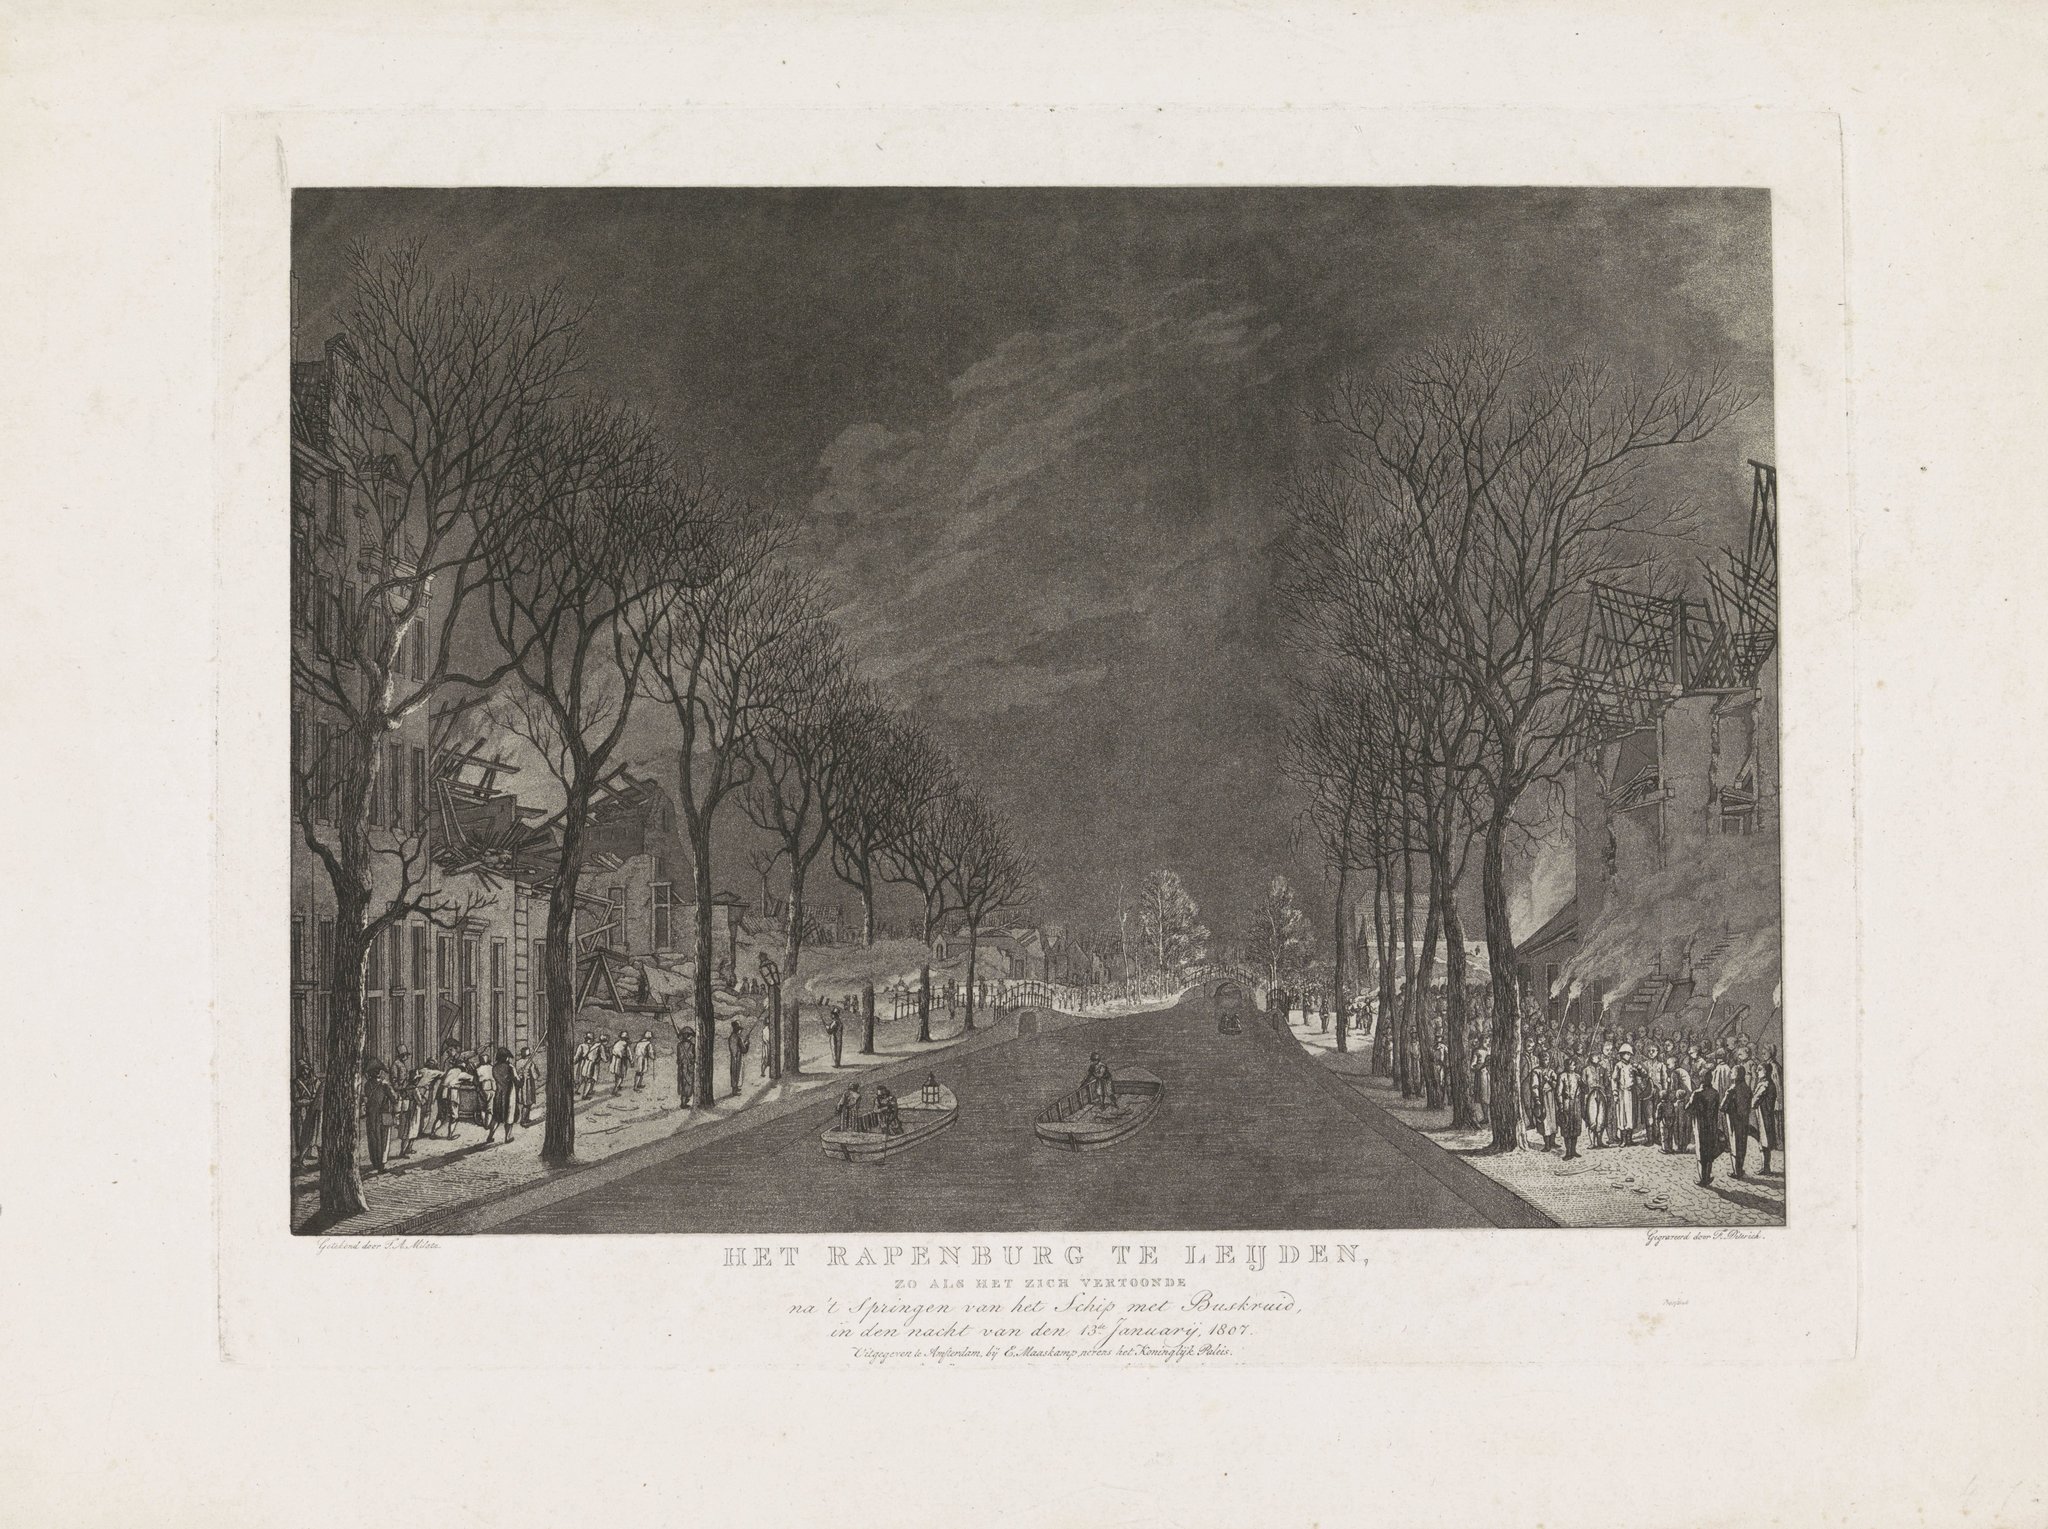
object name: print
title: Lodewijk Napoleon op de plaats van de ramp, 1807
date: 1807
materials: paper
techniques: aquatint, etching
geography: amsterdam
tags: louis napoleon (king of holland), gunpowder disaster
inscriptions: collector's mark: Lugt 2228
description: Koning Lodewijk Napoleon bezoekt 's avonds de plaats van de buskruitramp op het Steenschuur, een gracht in het verlengde van het Rapenburg, te Leiden, 12 januari 1807.